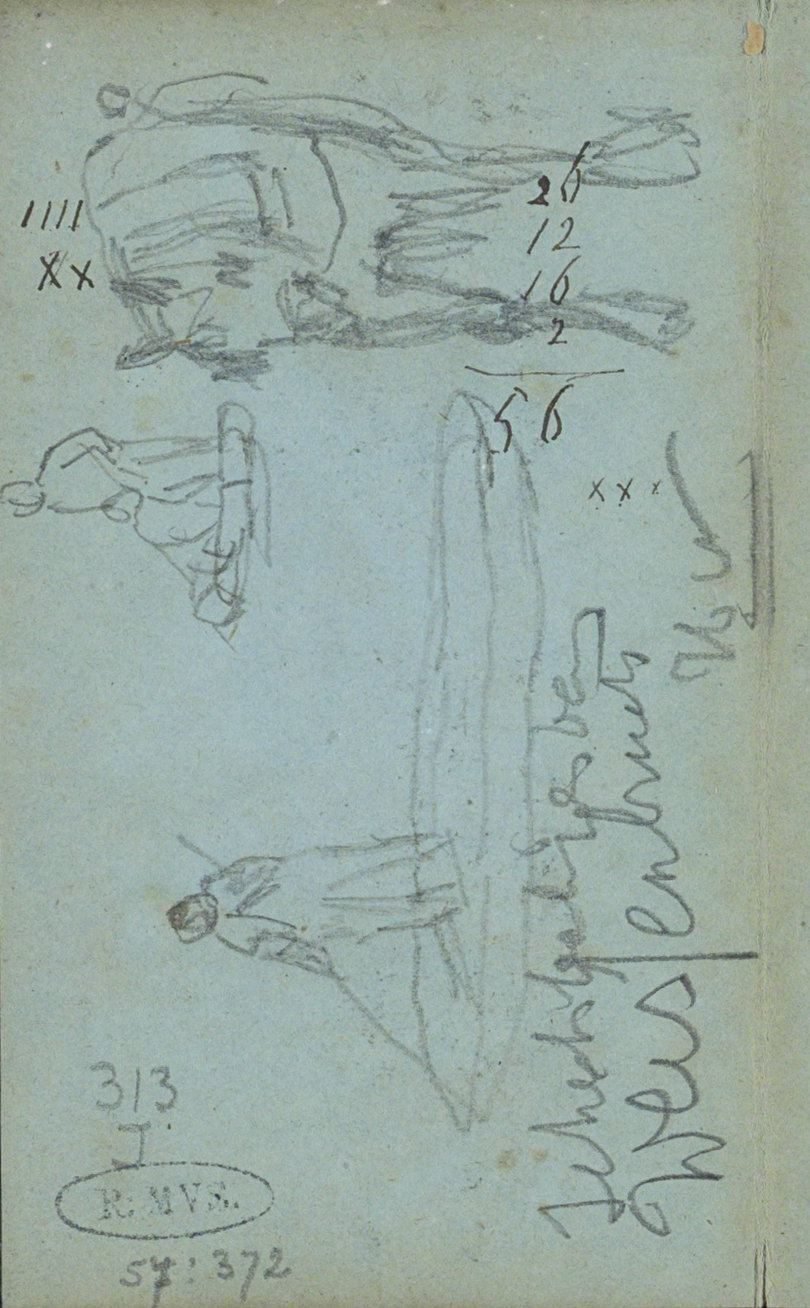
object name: sketchbook leaf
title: Figuren in roeiboten en een paard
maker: johan hendrik weissenbruch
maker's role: draughtsman, painter, print maker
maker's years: 1824-1903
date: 1834-1903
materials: paper, pencil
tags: rowing-boat, canoe, etc., horse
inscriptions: annotation: ‘[...]’, annotation: ‘schetsboekje van/ Weissenbruch’, collector's mark: Lugt 2228a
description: Voorste vaste schutblad uit een schetsboek met 32 bladen.